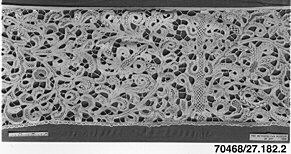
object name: flounce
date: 1601-1700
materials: lace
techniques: lace